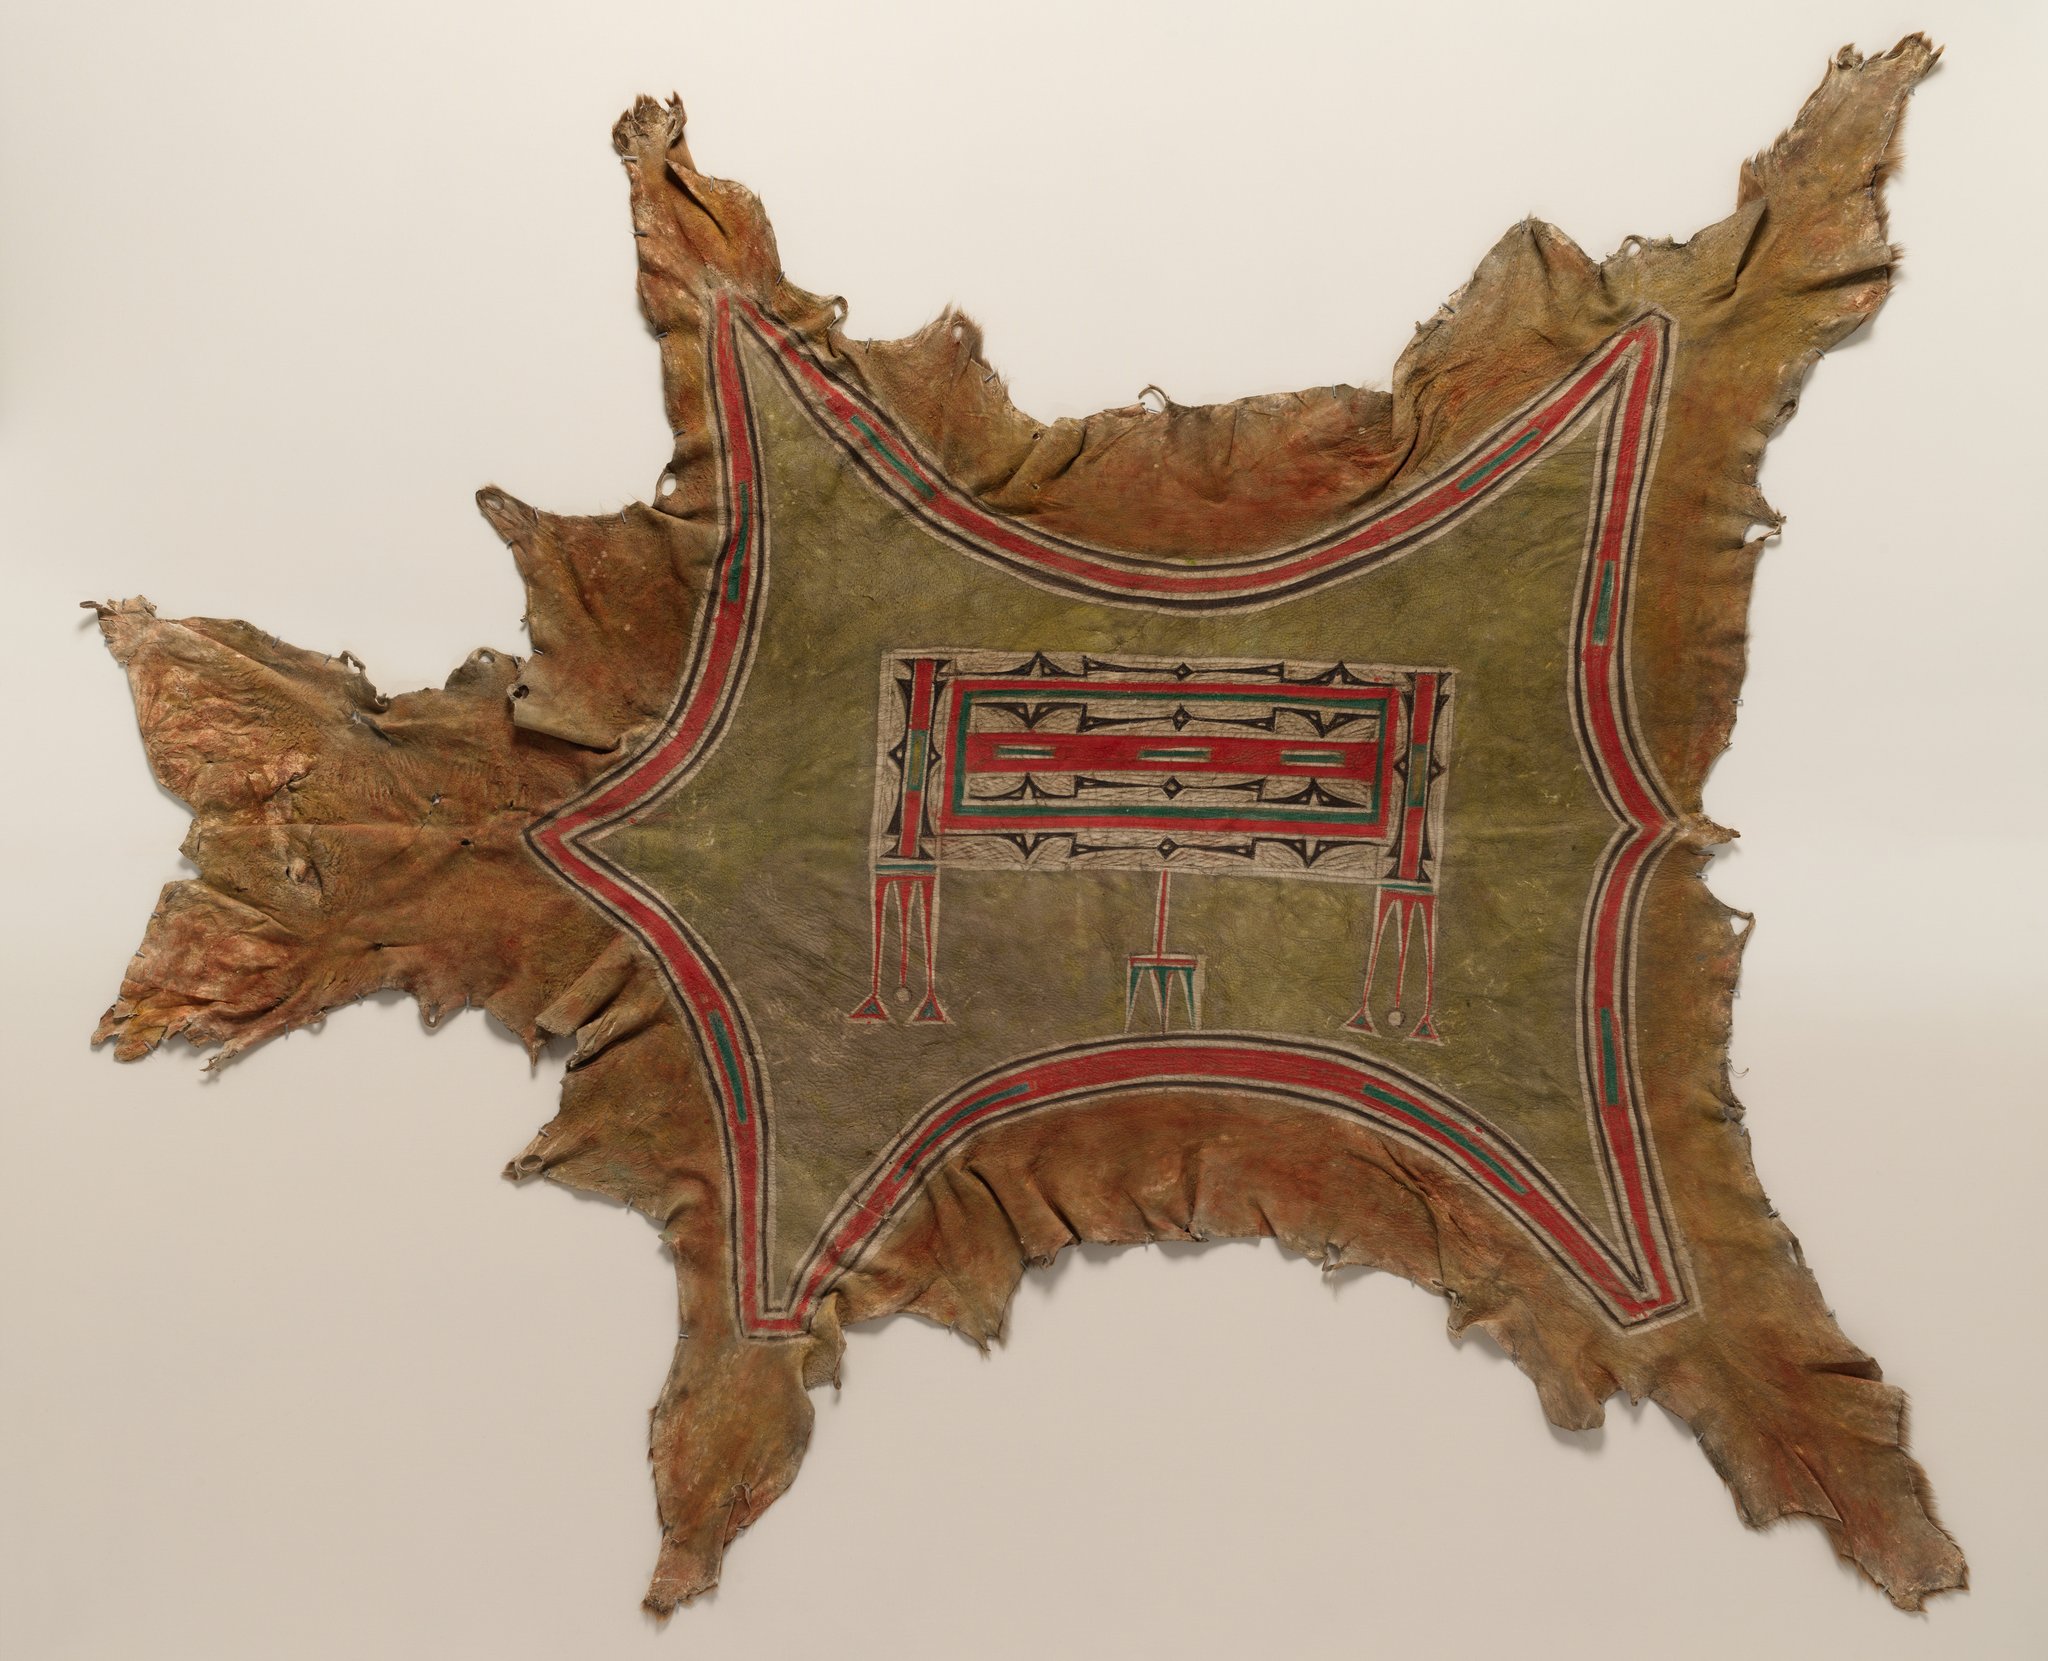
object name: girl's robe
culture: arapaho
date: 1875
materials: leather, pigment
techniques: tanning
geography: united states